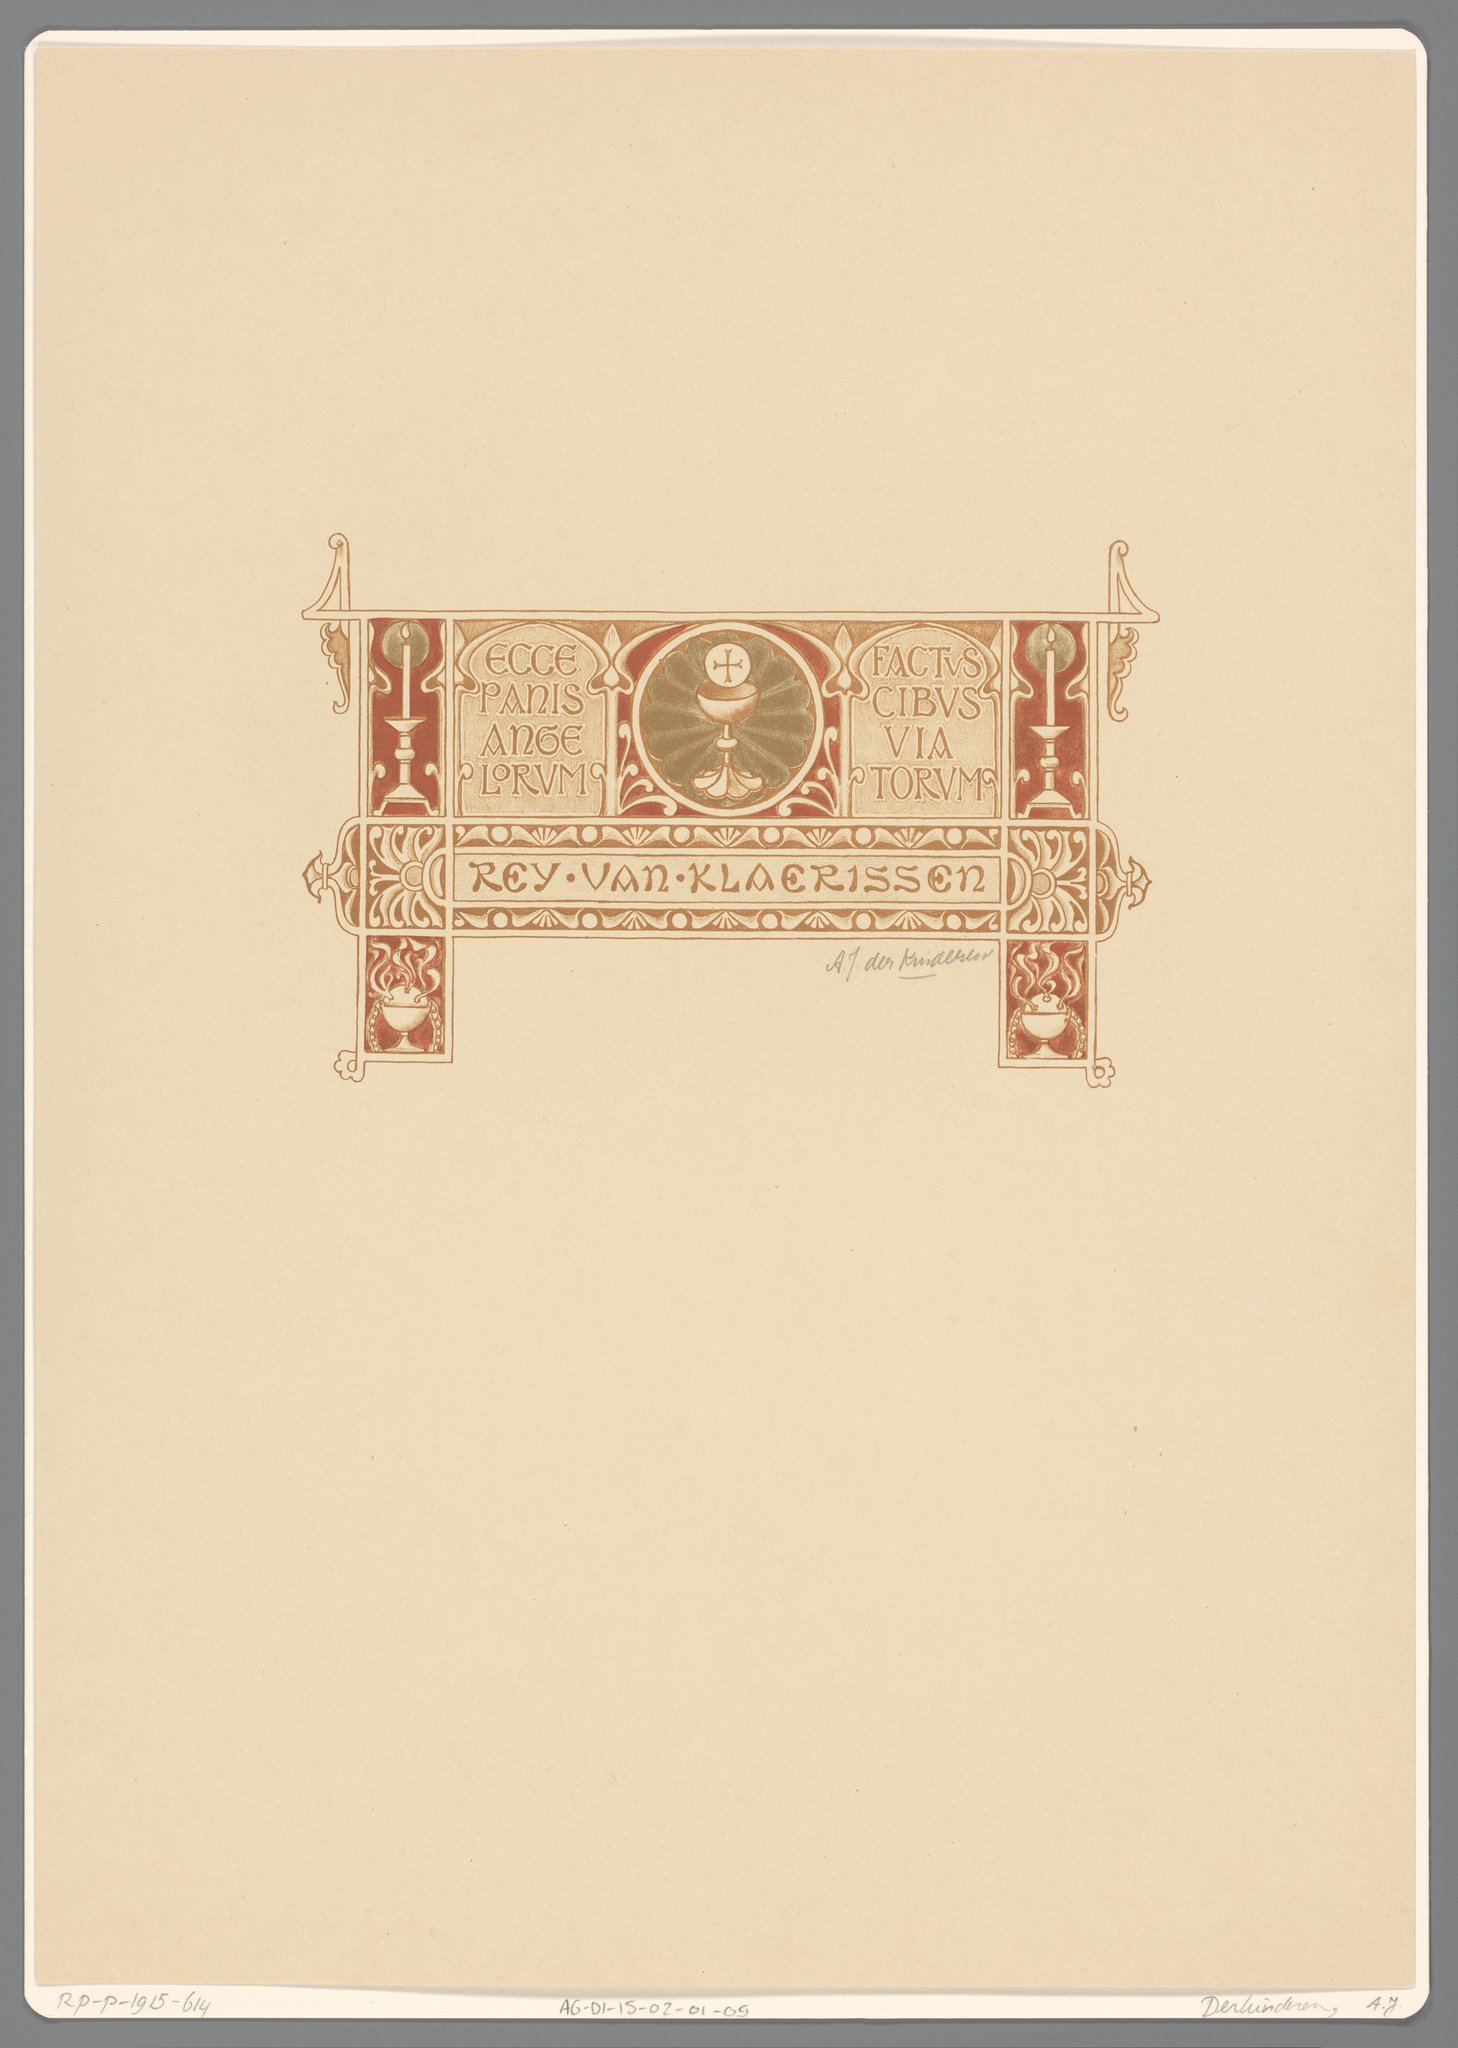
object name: book illustration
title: Rey van klaerissen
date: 1894-1901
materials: paper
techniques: lithograph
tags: chalice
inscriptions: collector's mark: Lugt 2233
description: Een horizontale, decoratieve titelband waarin de rei van clarissen wordt aangekondigd. Bovenaan een miskelk. Links de tekst 'ecce panis angelorum', rechts de tekst 'factus cibus viatorum'.